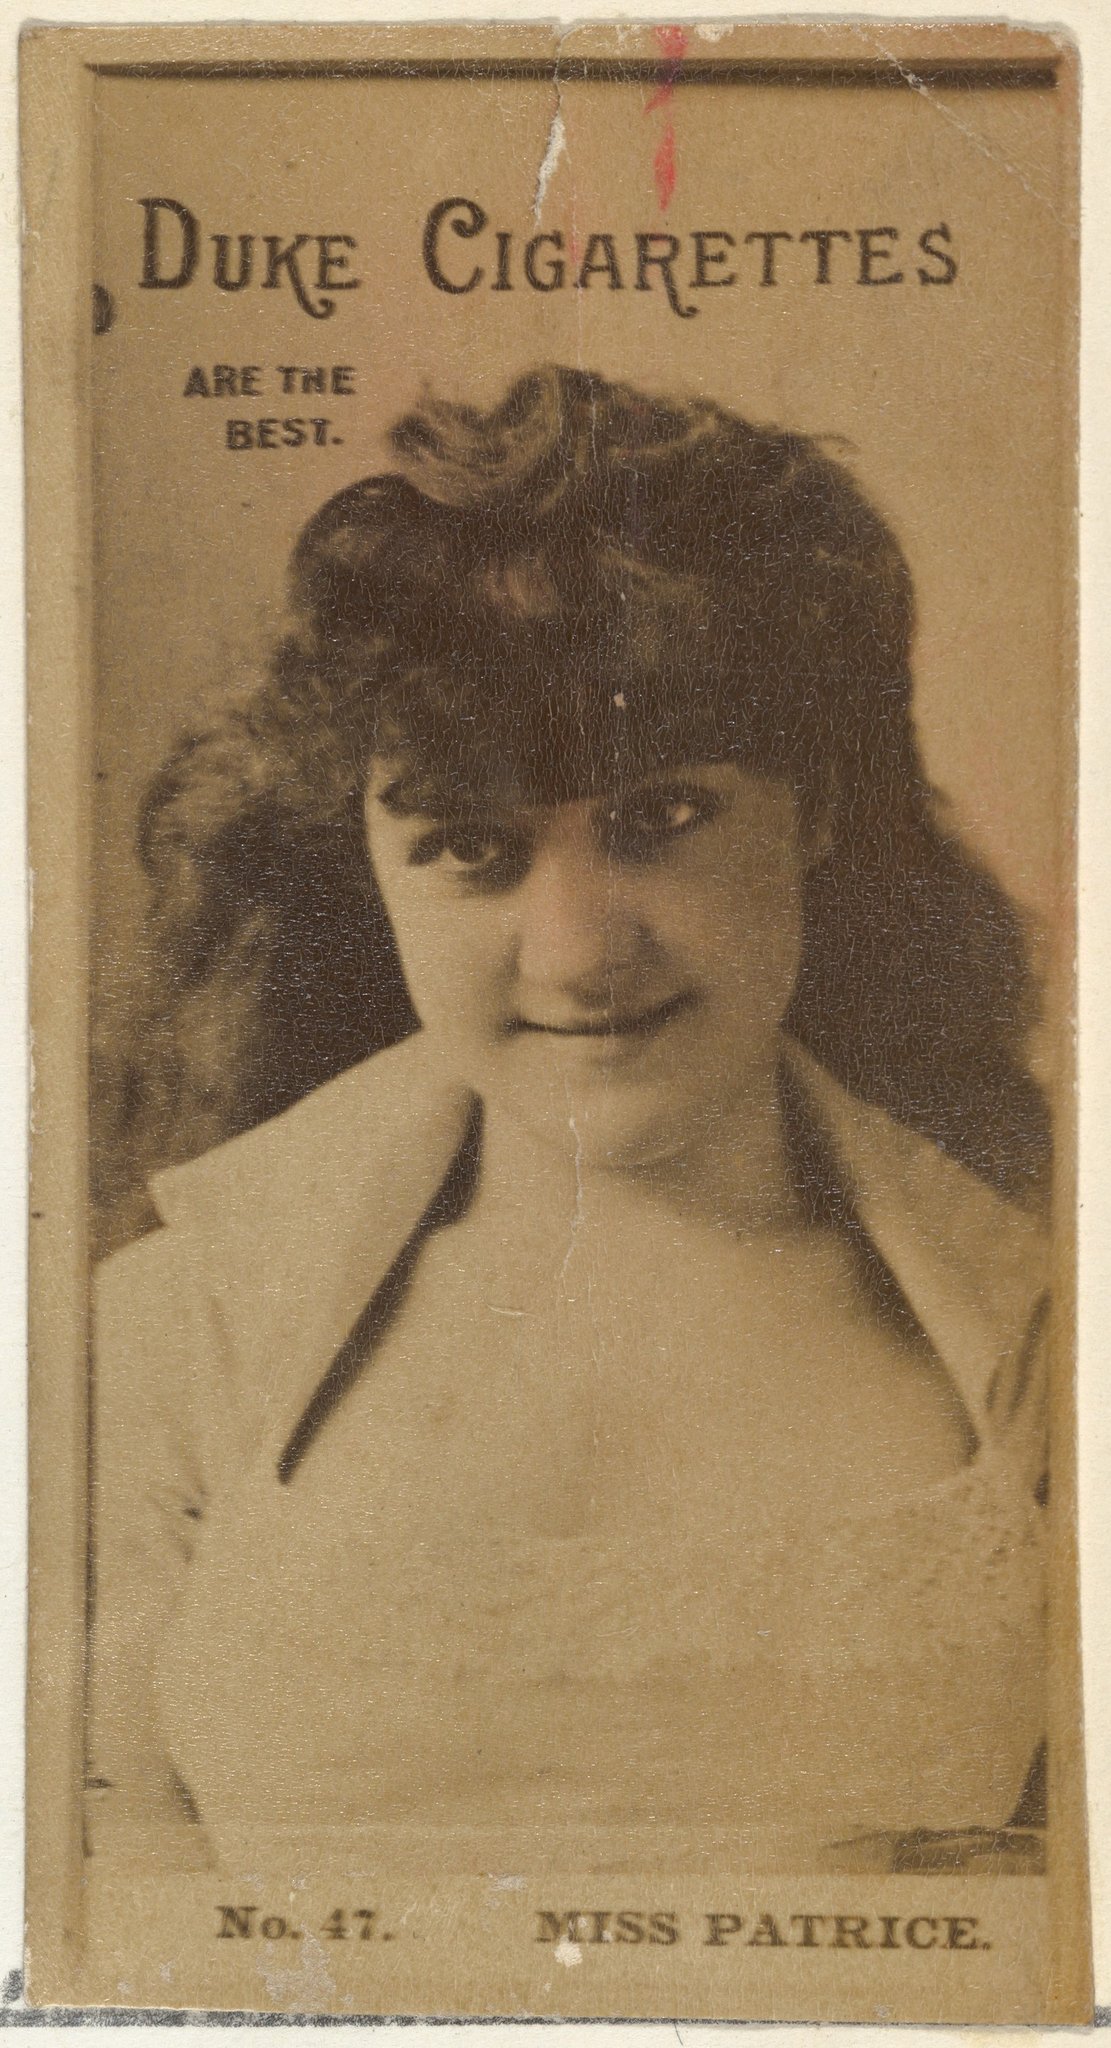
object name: photograph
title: Card Number 47, Miss Patrice, from the Actors and Actresses series (N145-6) issued by Duke Sons & Co. to promote Duke Cigarettes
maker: w. duke, sons & co.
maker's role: publisher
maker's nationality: american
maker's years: 1870-1920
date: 1880-1889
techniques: albumen silver print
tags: portraits,women,actresses